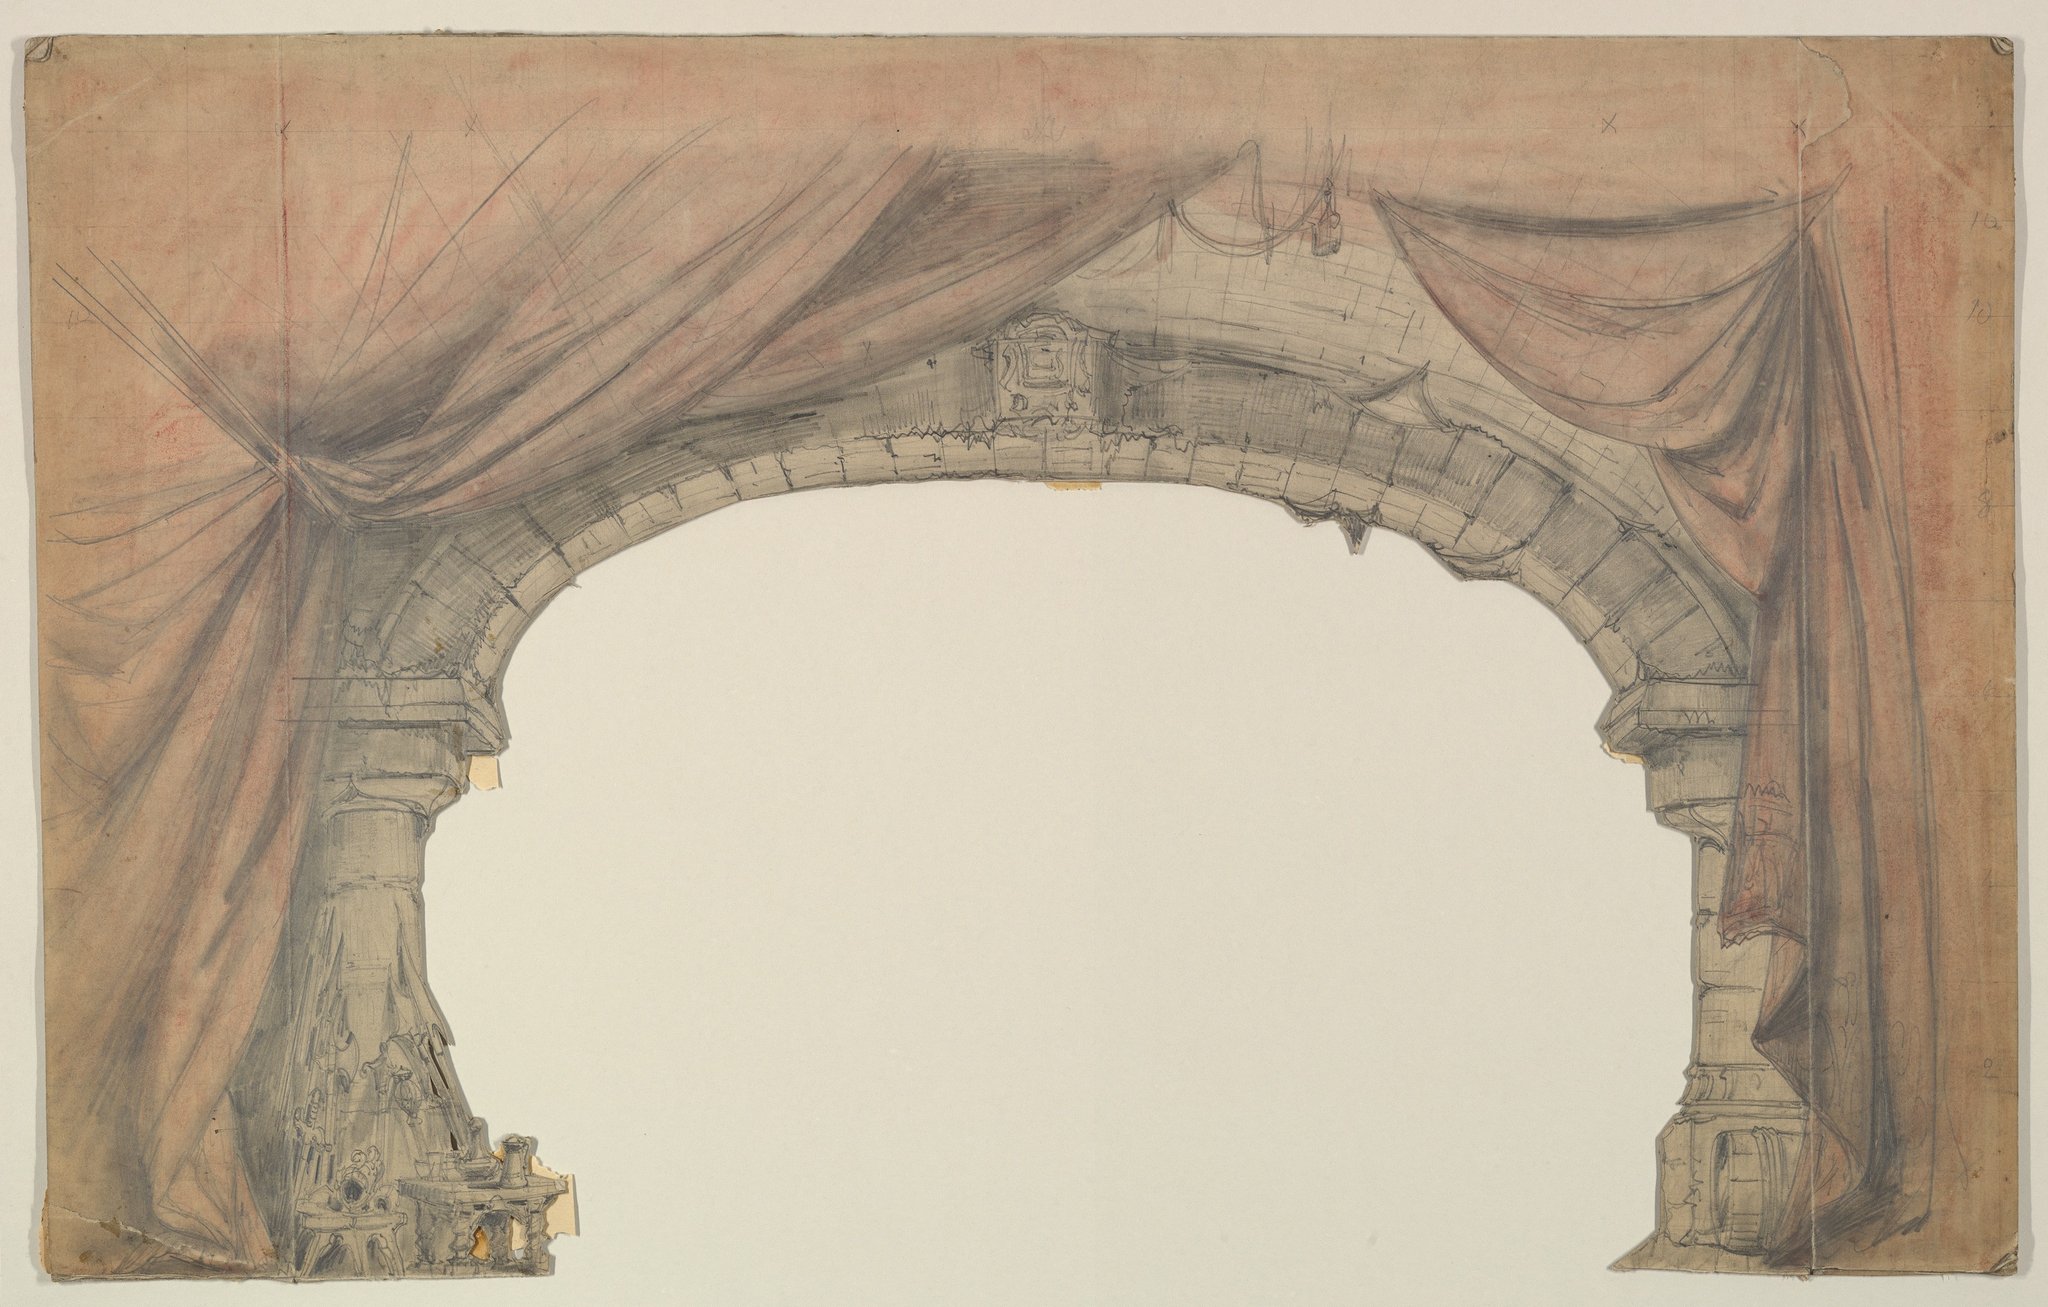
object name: drawing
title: Design for a Stage Set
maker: eugène cicéri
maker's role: artist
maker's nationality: french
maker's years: 1813-1890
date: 1830-1890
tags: stage design